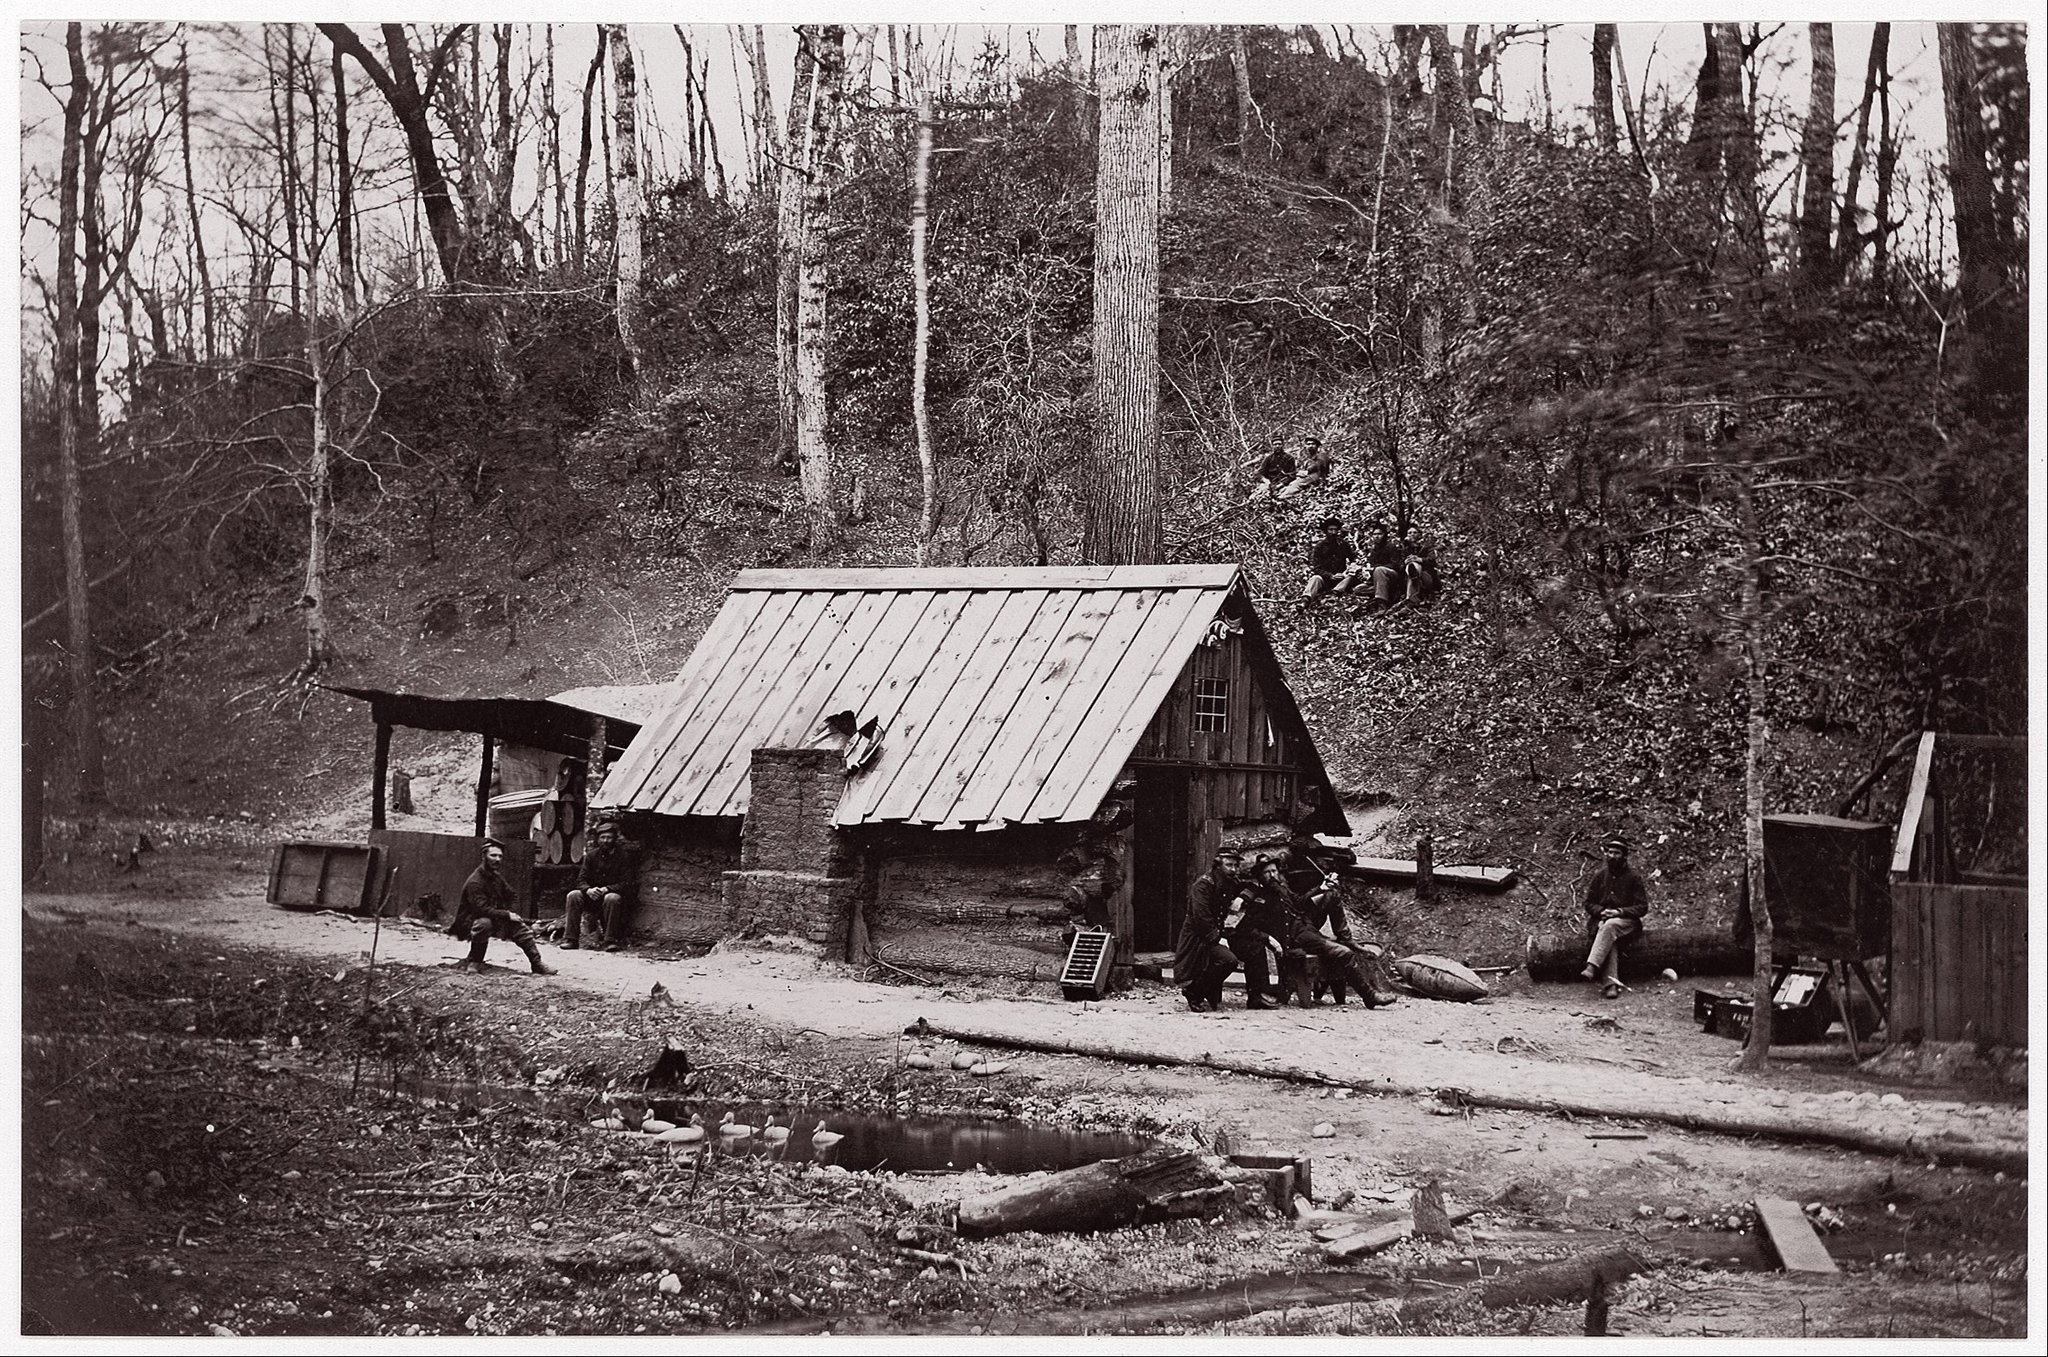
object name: photograph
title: [Prof. Maillefert and Naval Officers Employed to Remove Gunpowder from Confederate Torpedoes, James River, Virginia]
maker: egbert guy fowx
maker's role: artist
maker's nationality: american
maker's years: 1821-1889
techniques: albumen silver print, glass negative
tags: soldiers,american civil war